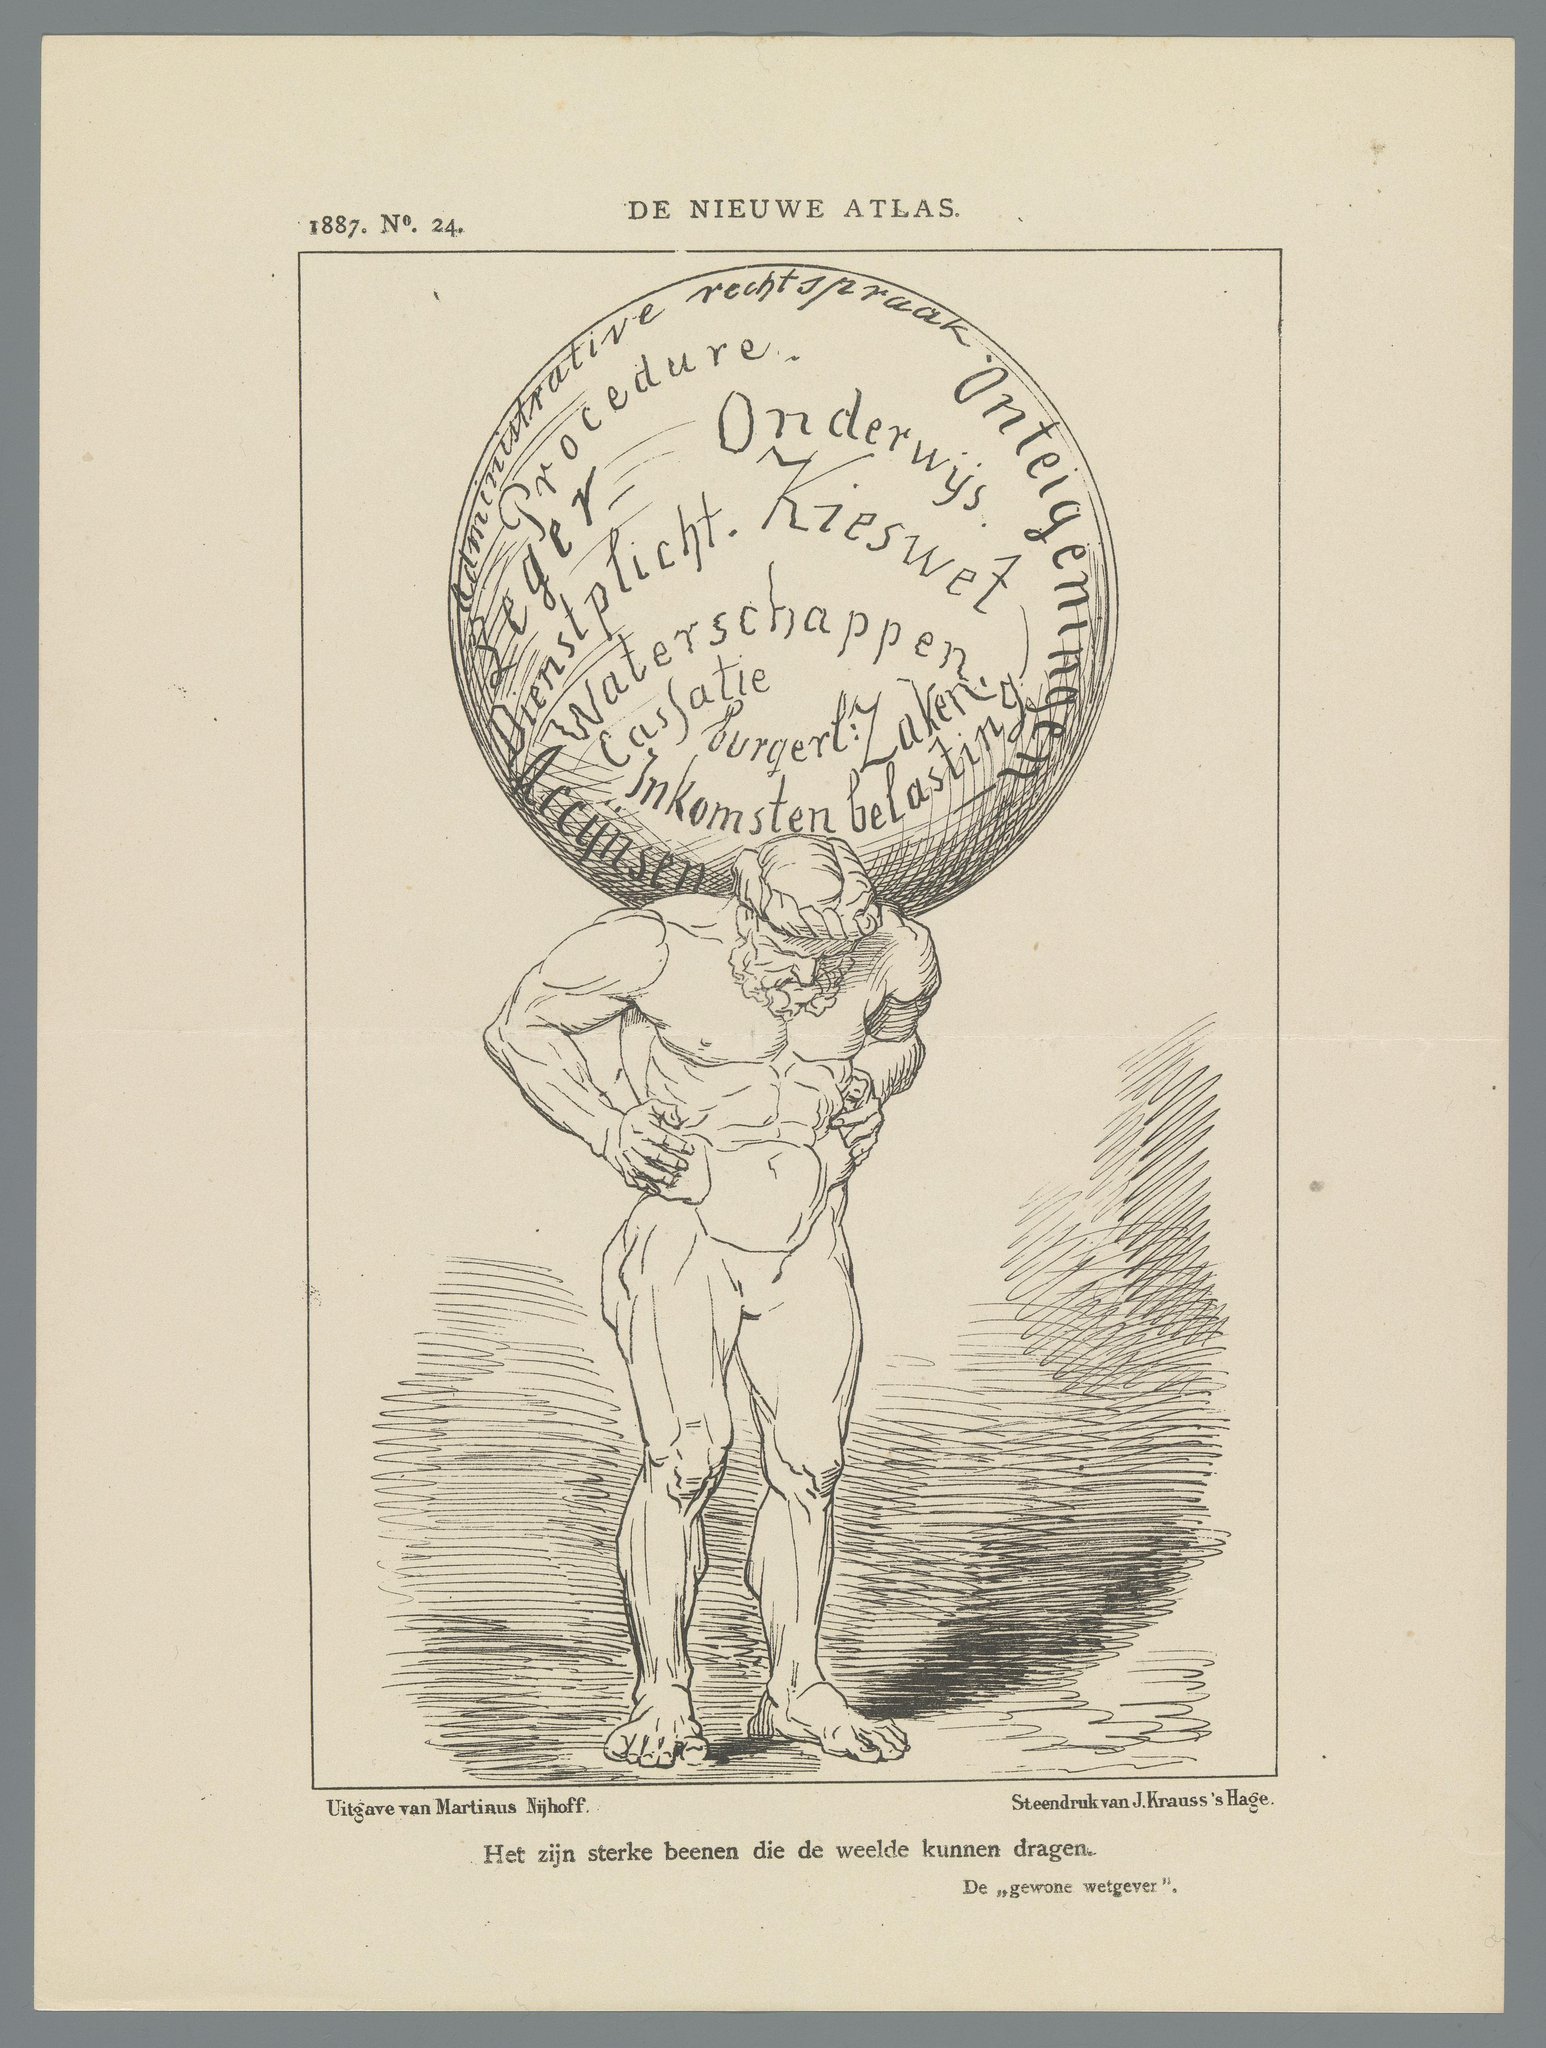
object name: print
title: Spotprent met Atlas met de wereld op zijn schouders, 1887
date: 1887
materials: paper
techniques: lithograph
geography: the hague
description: Spotprent met Atlas met de politieke wereld op zijn schouders draagt. Plaat verschenen bij het weekblad De Nederlandsche Spectator, nr. 24, 1887.